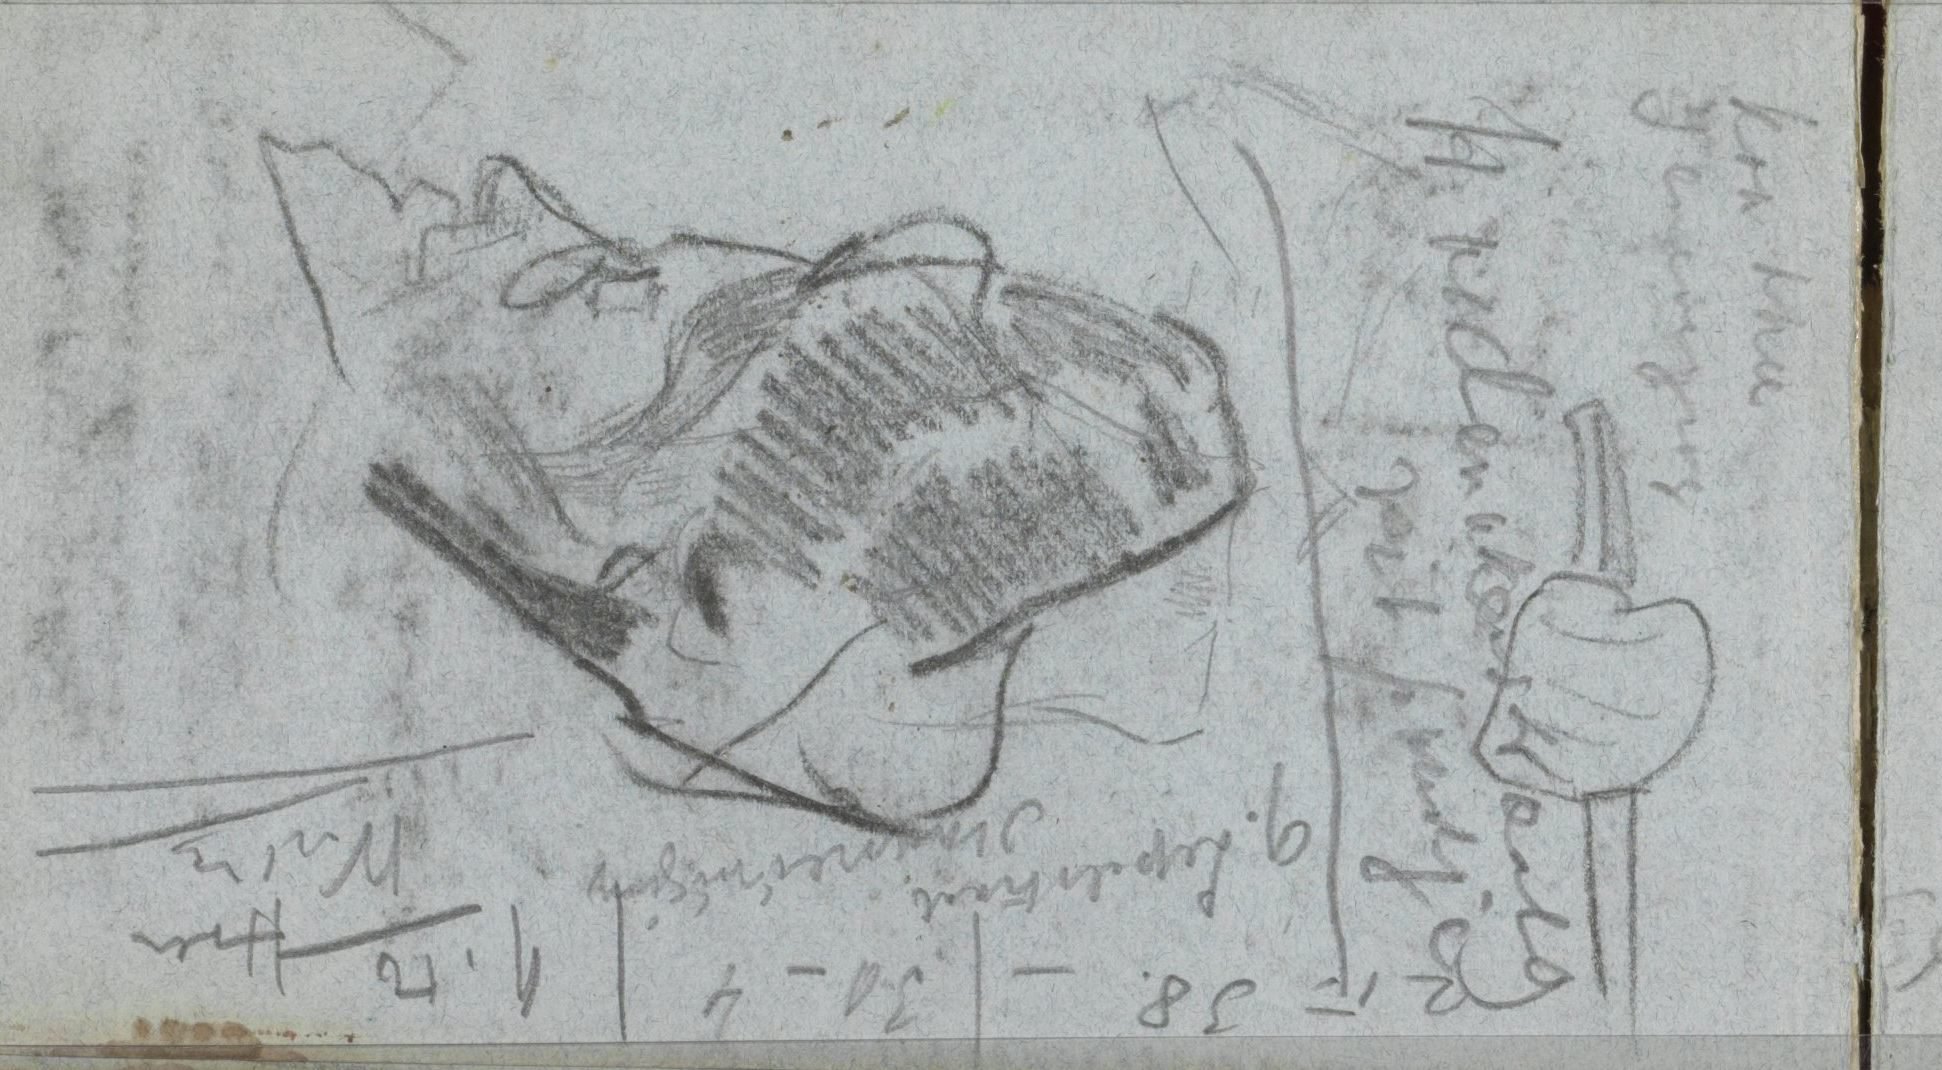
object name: endleaf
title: Hoofd van een oude vrouw, in profiel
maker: george hendrik breitner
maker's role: draughtsman, painter, print maker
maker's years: 1857-1923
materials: chalk, paper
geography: amsterdam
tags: old woman (+ sideview, profile), head (human) - aa - female human figure (+ sideview, profile)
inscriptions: annotation: ‘[...] Hoedemakersstraat 9/ [...] prentje/ [...] g Lepelstraat/ [...]’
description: Ze draagt een bril en een hoed. Pagina 65, vrij schutblad, uit een schetsboek met 32 bladen.